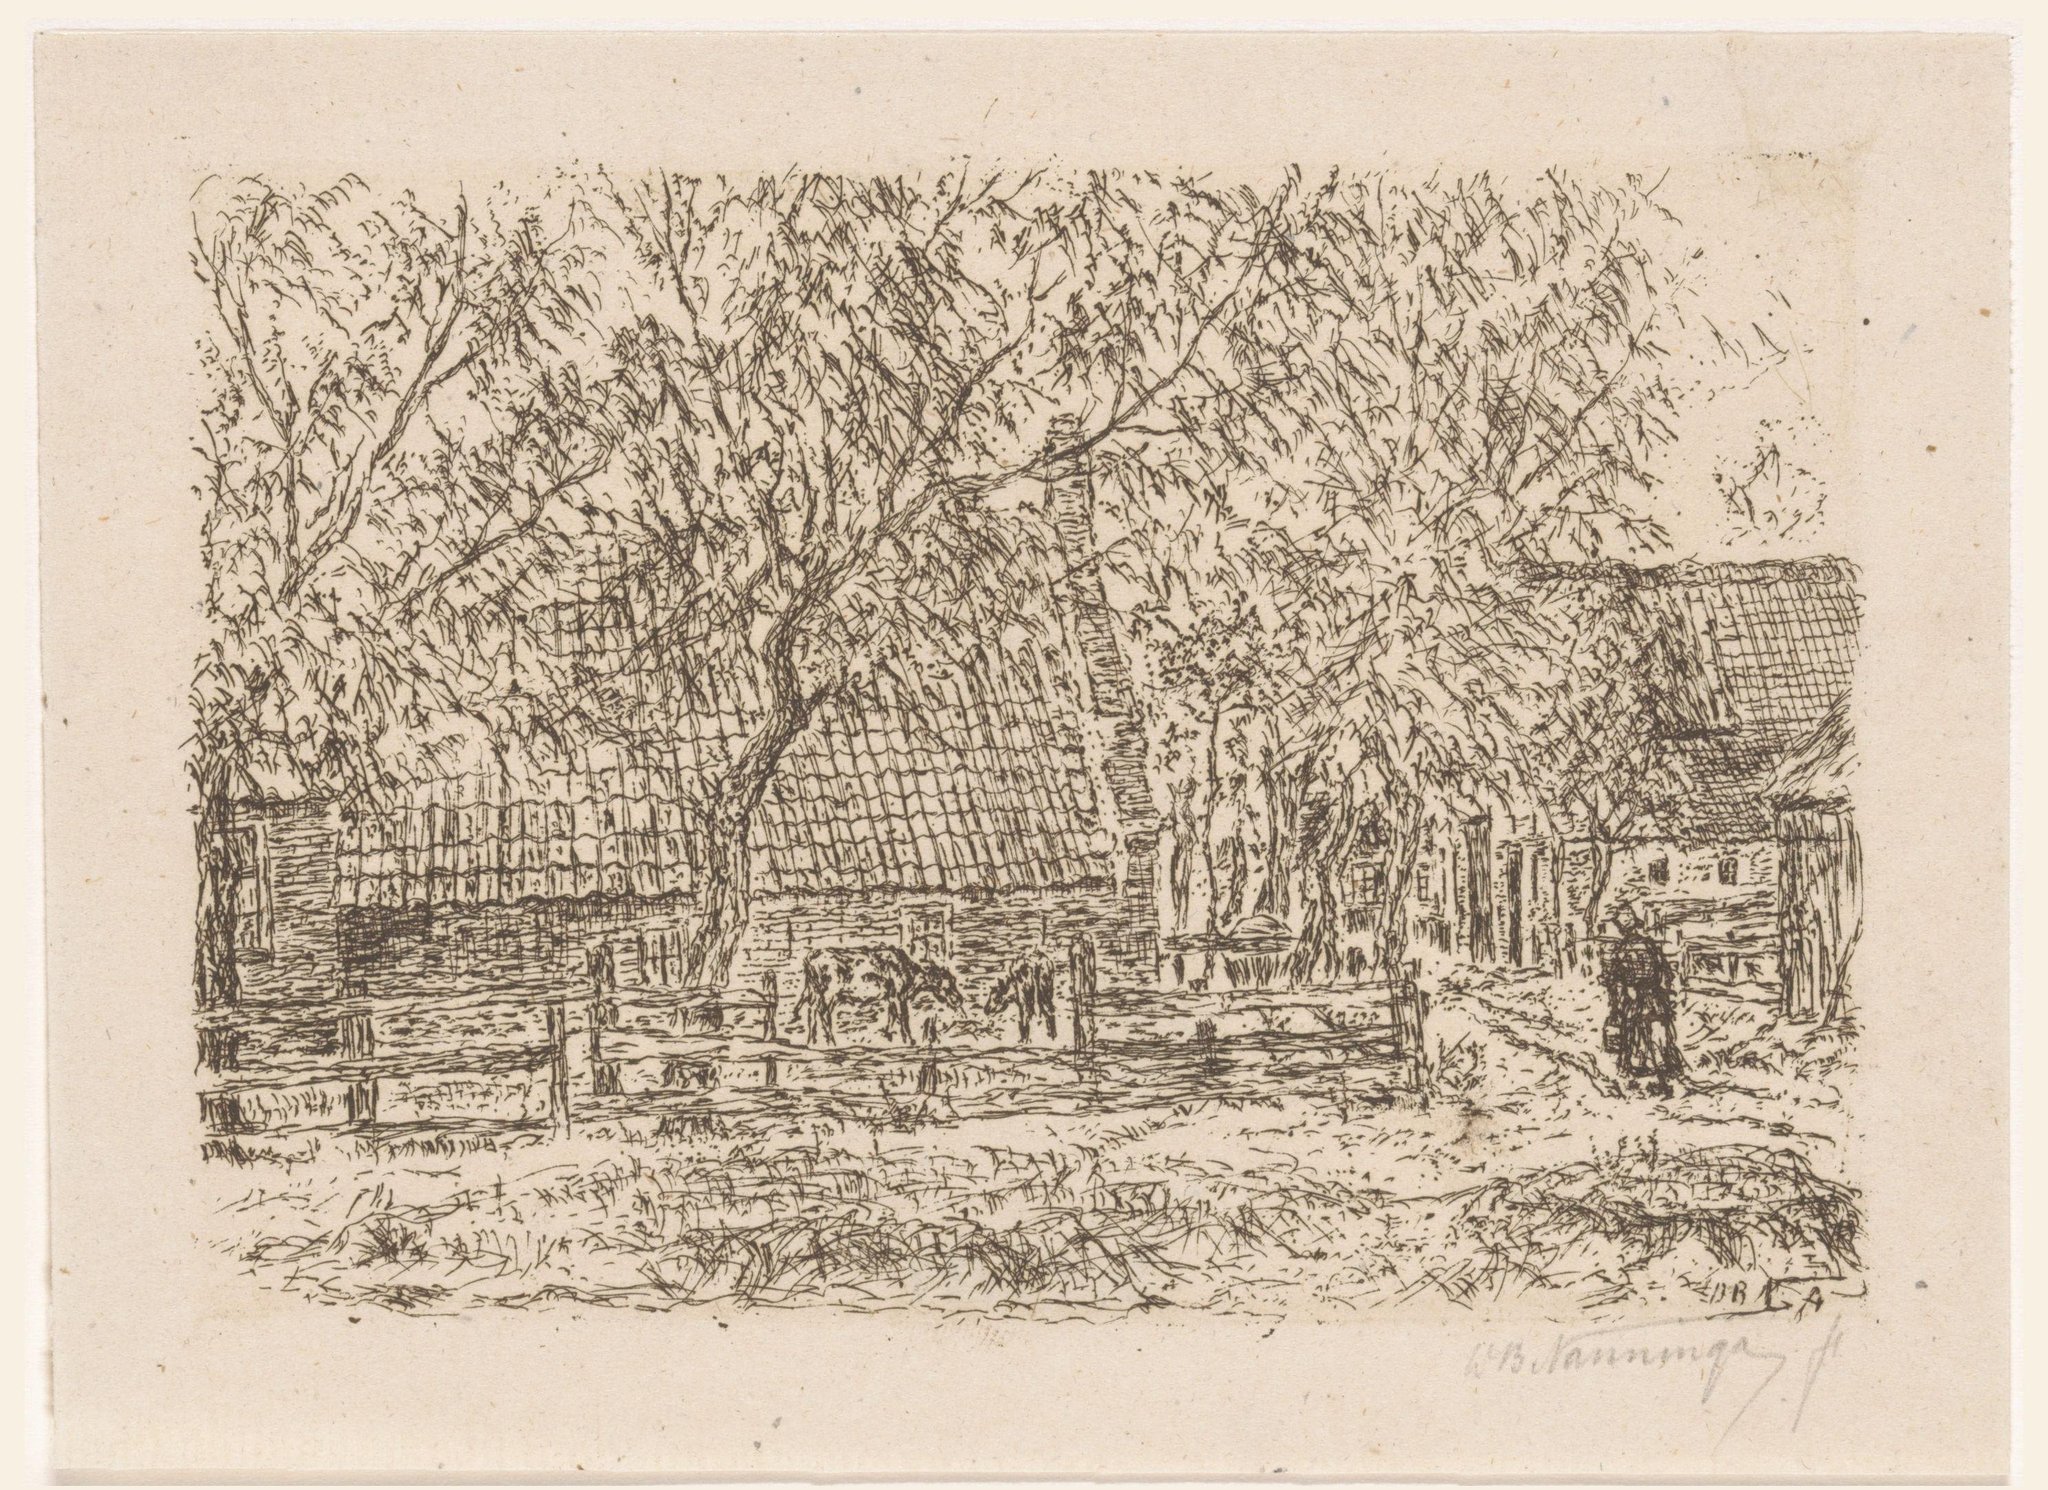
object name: print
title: Dorpsgezicht met grazend vee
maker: dirk berend nanninga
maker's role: print maker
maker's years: 1868-1954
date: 1878-1931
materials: paper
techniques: etching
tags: village, bovine cattle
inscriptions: collector's mark: Lugt 2228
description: Vooral staan twee runderen te grazen binnen een omheining. Rechts loopt een vrouw over de dorpsweg.